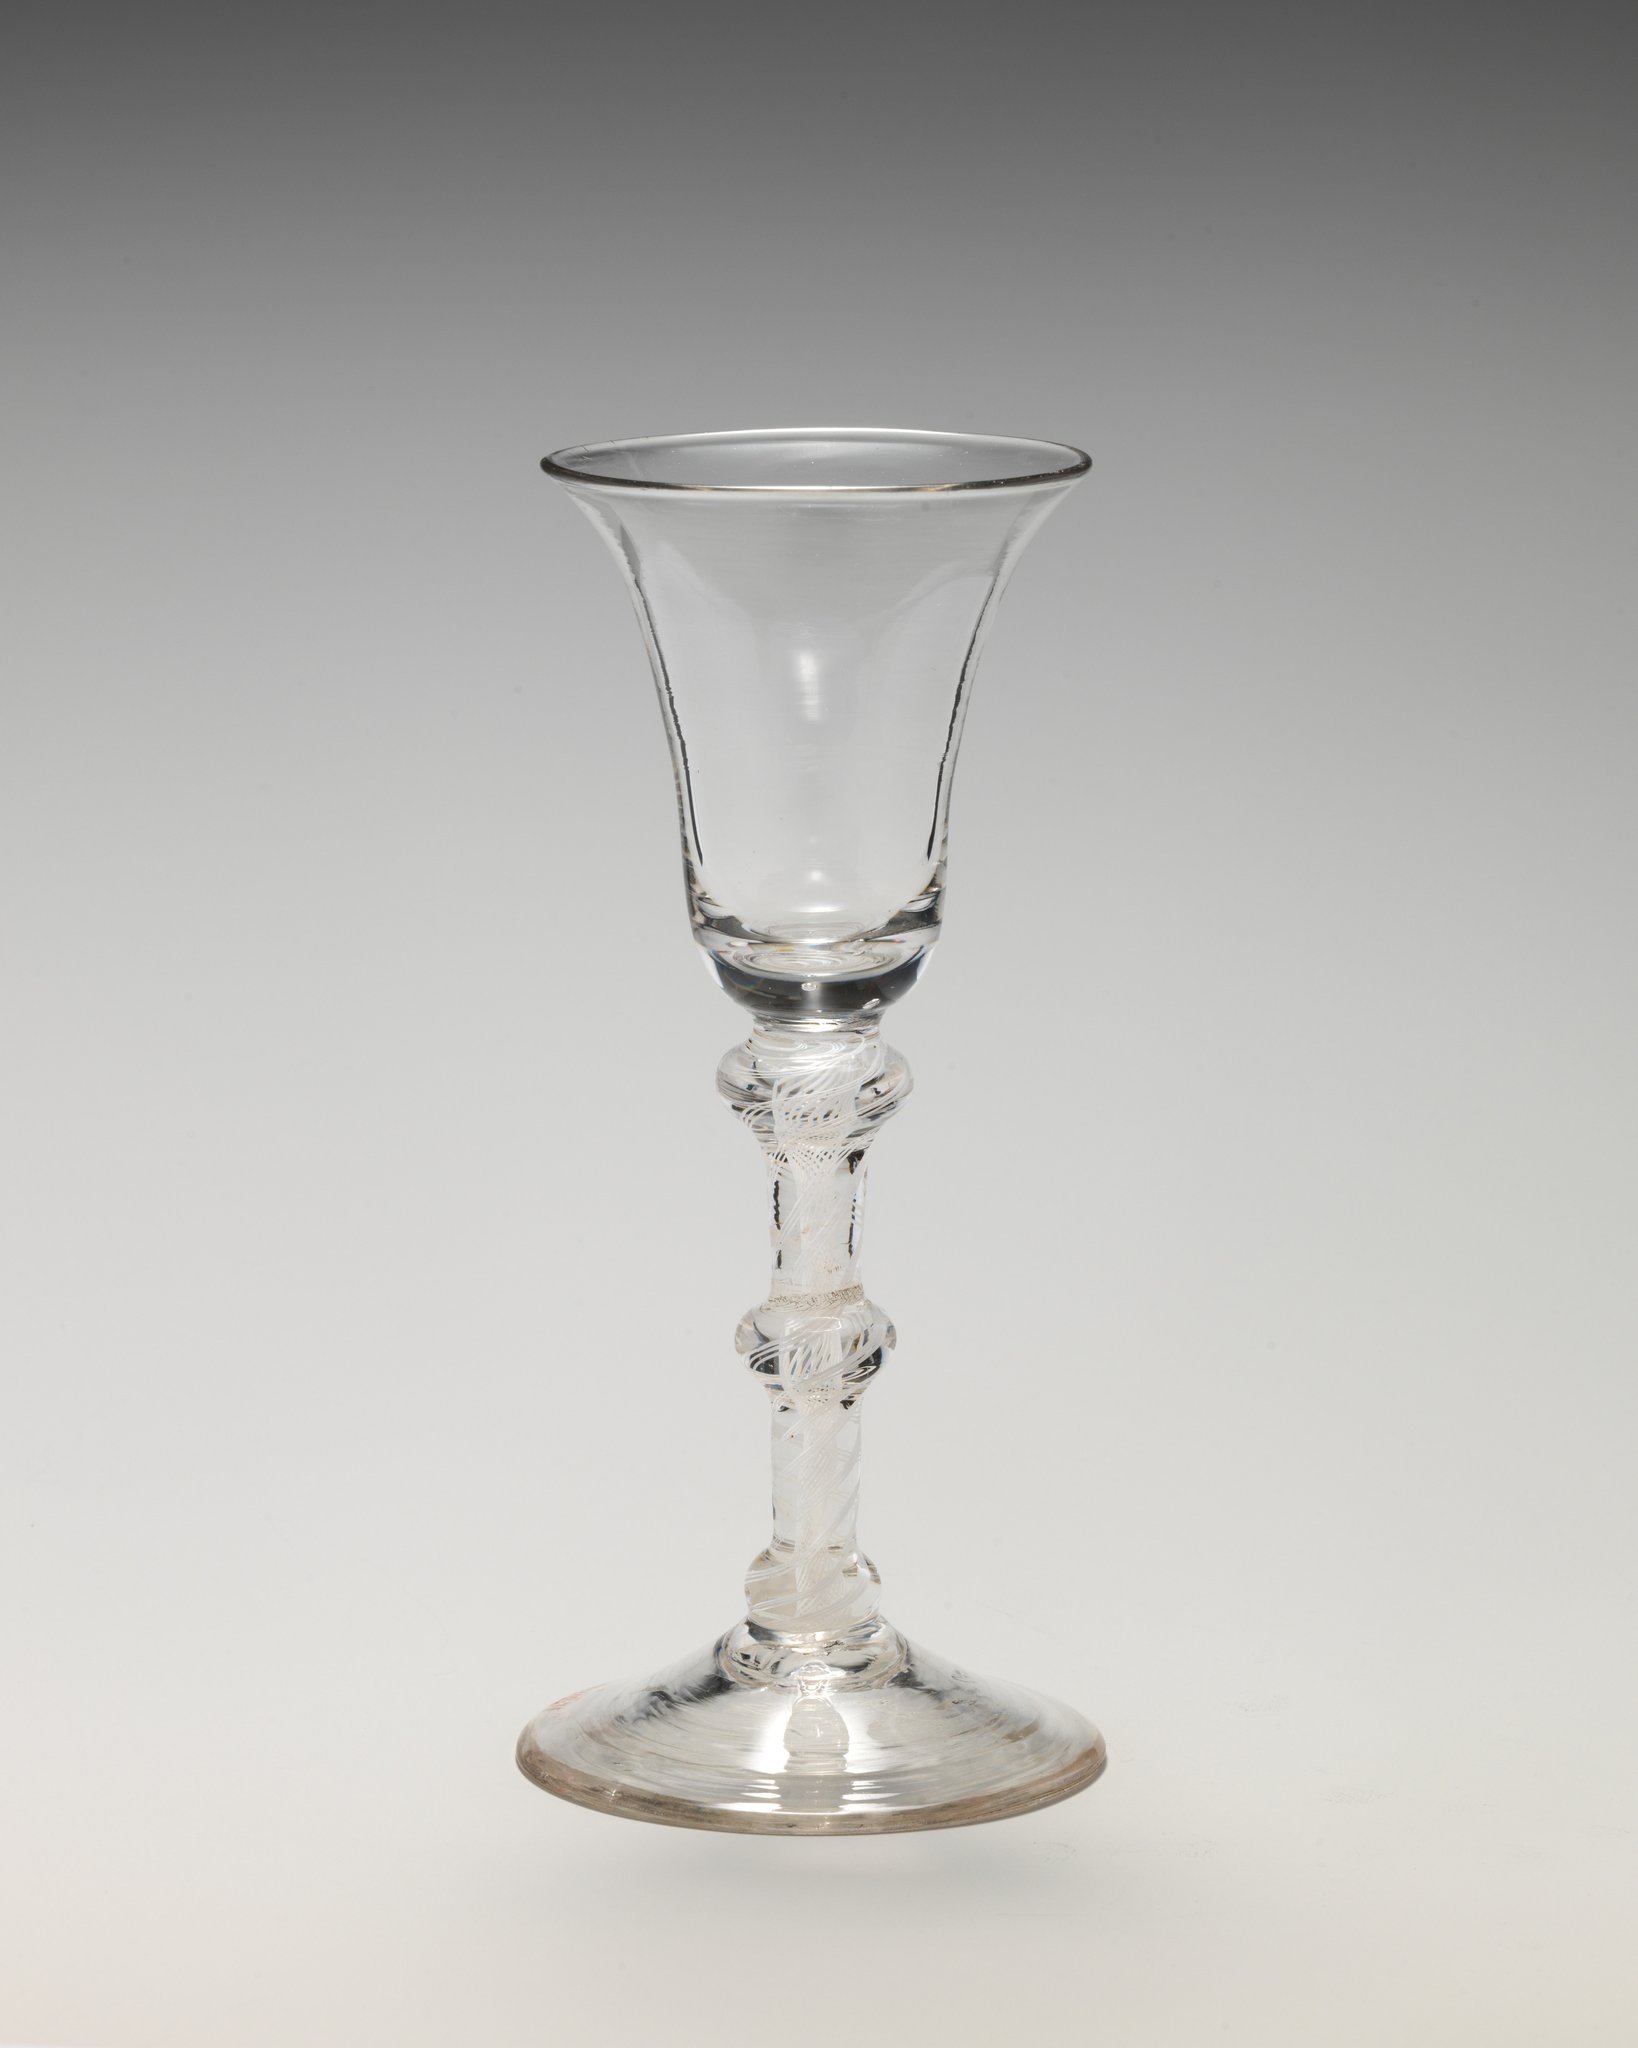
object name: wineglass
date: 1701-1800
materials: glass